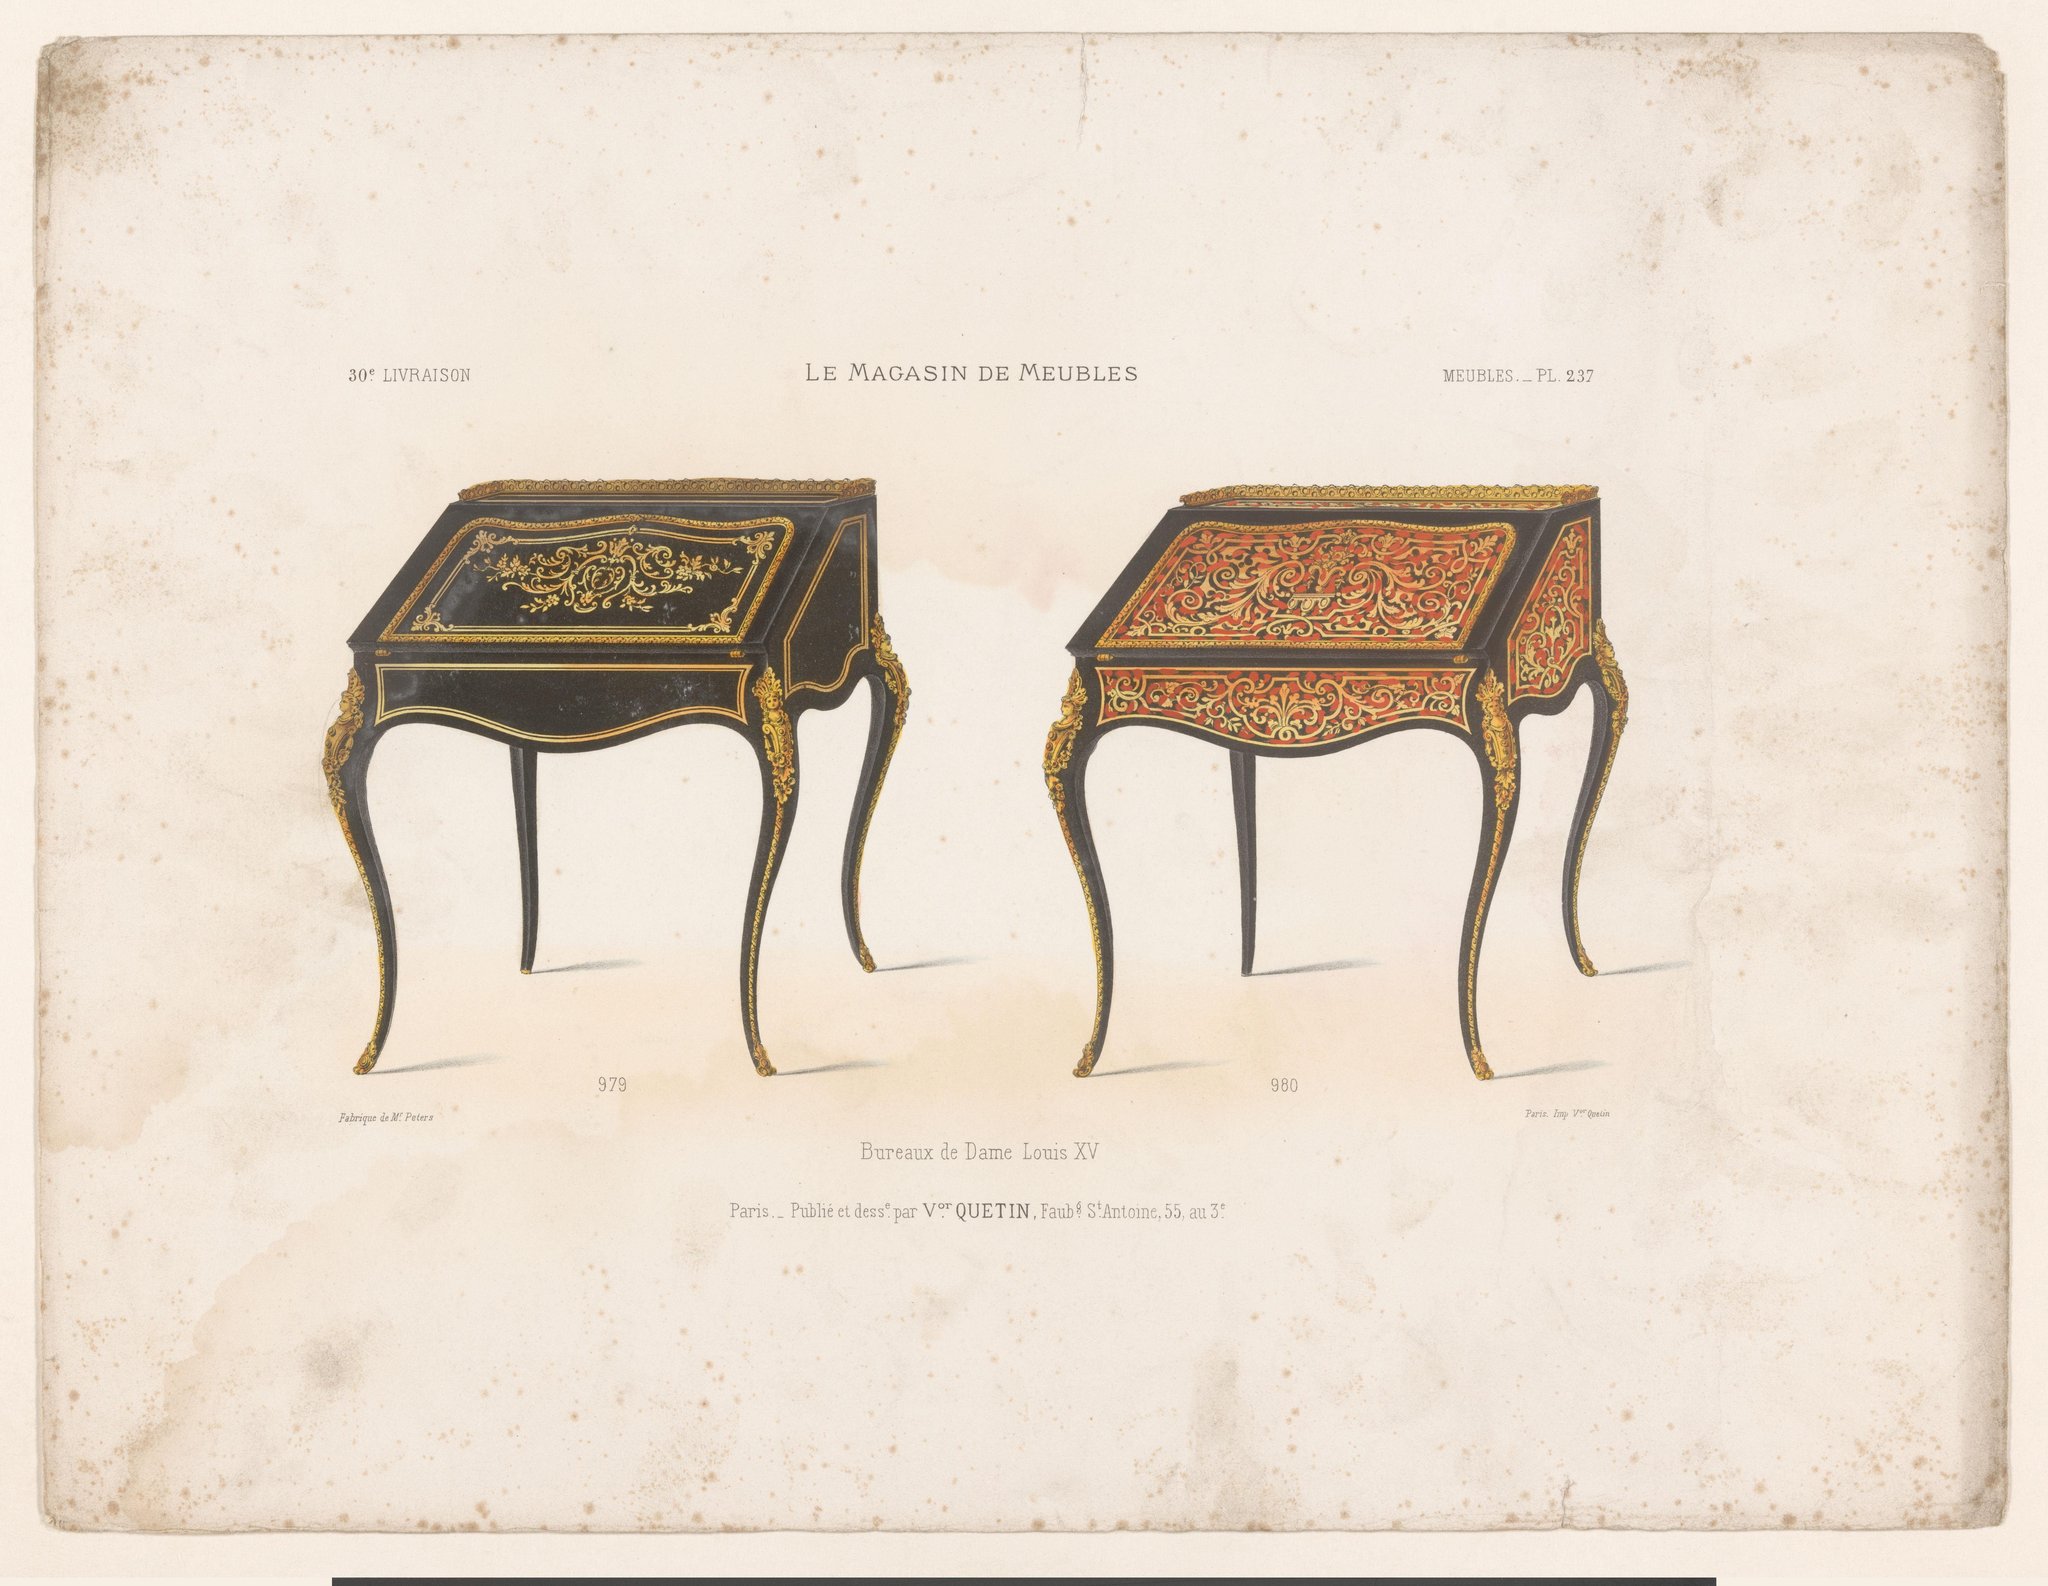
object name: print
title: Twee bureaus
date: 1832-1877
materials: paper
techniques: hand coloring, lithograph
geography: paris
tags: writing-table, writing-desk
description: Twee damesbureaus in de Lodewijk XV-stijl. Prent uit 30e Livraison.